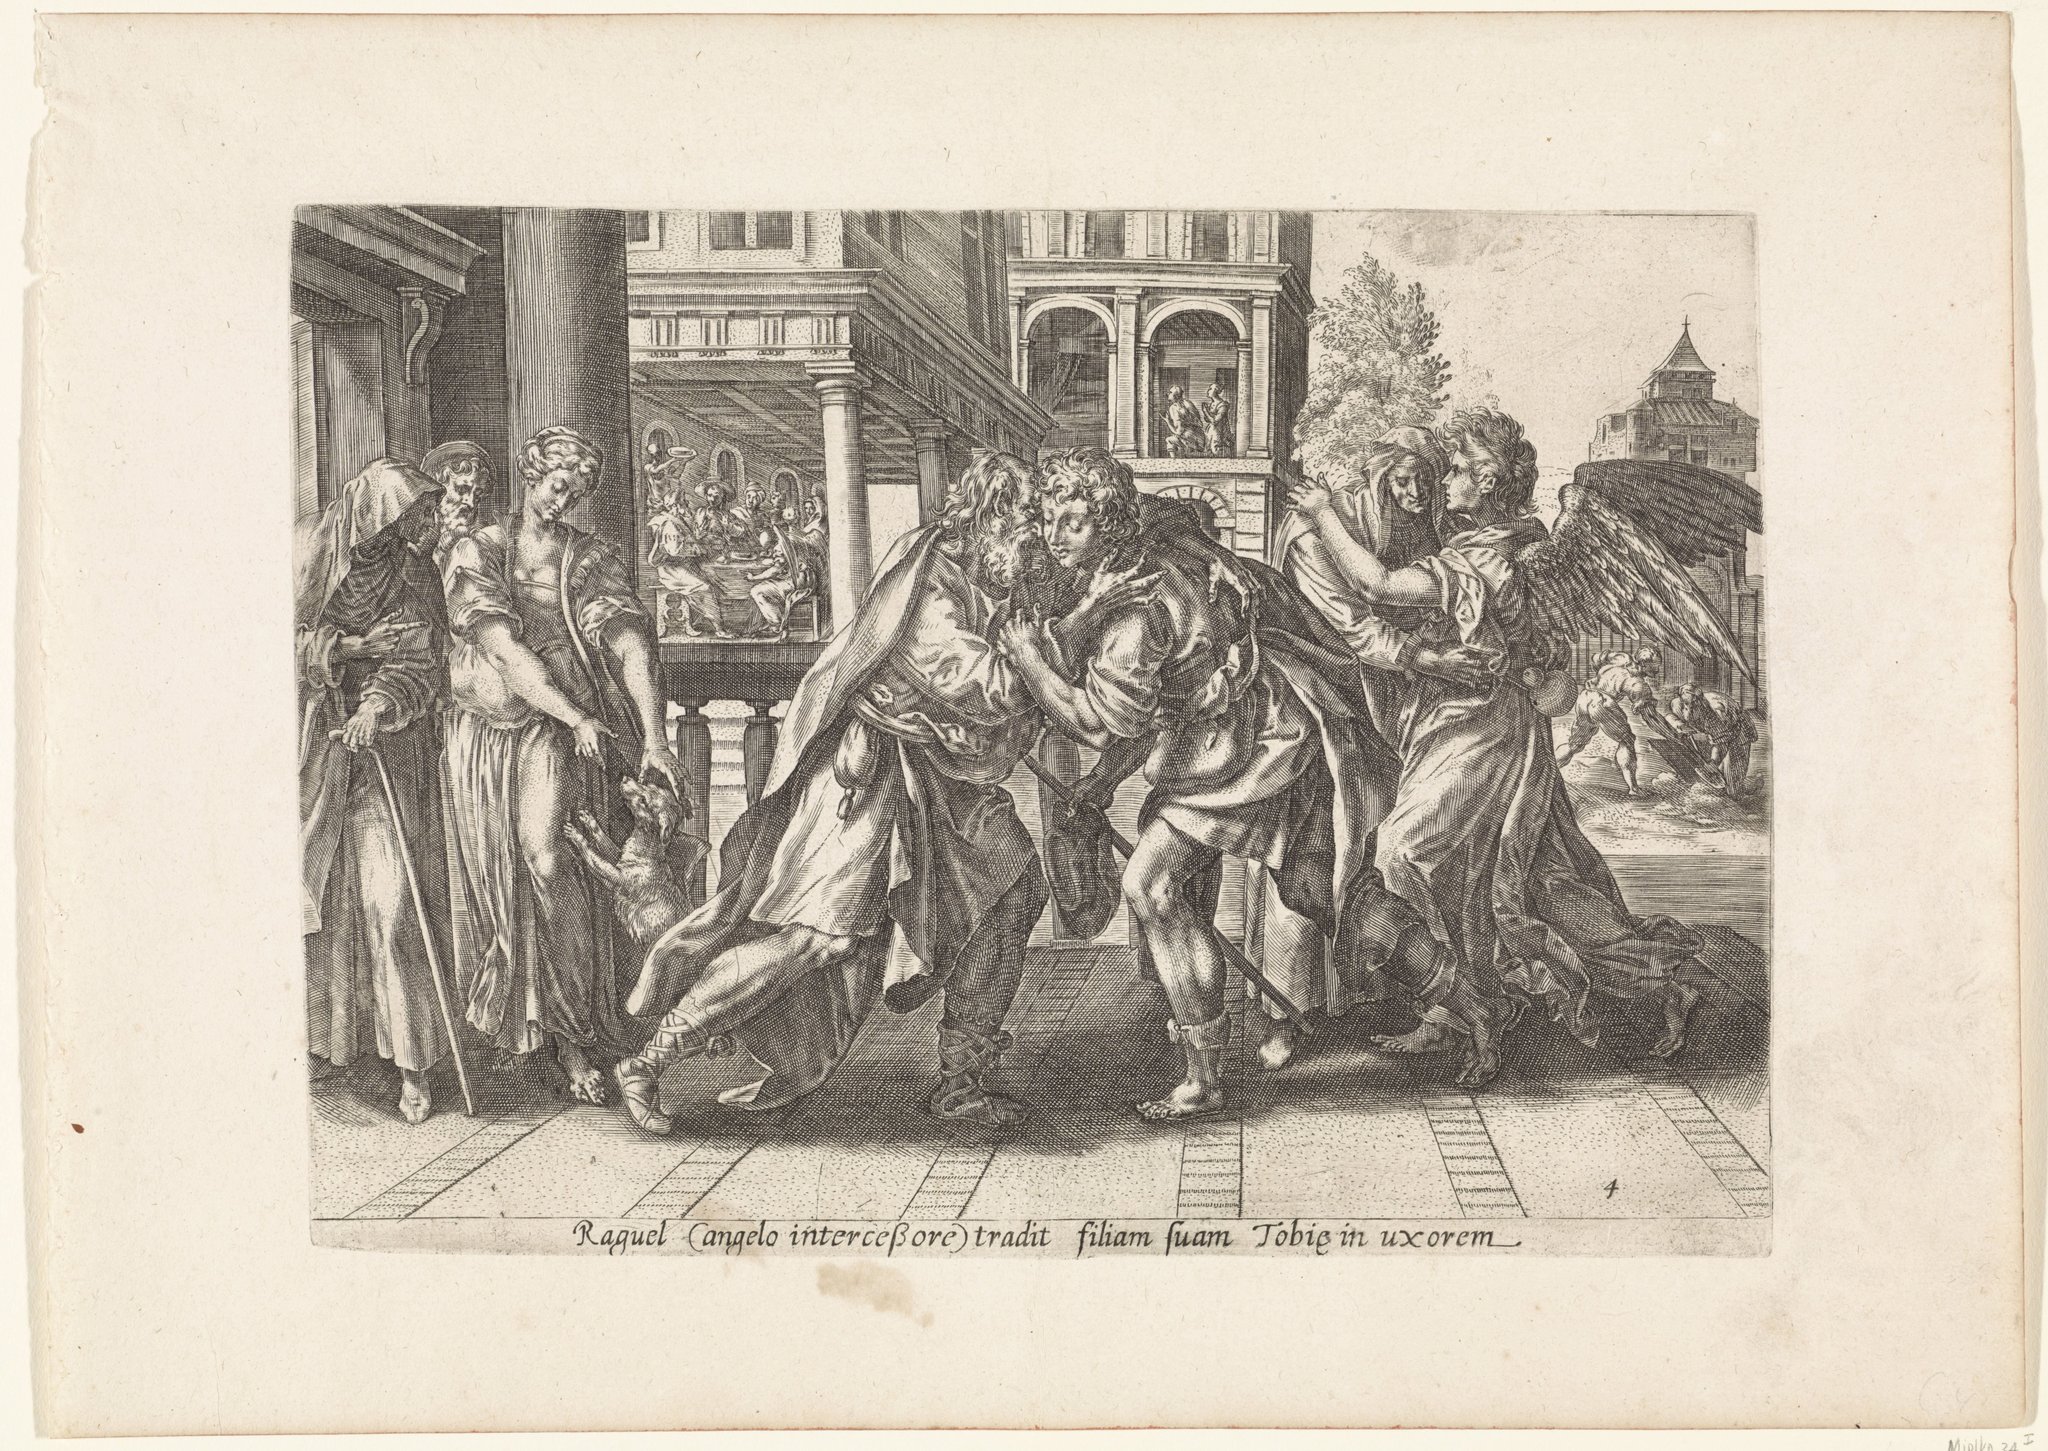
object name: print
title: Geschiedenis van Tobias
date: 1585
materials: paper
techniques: engraving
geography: antwerp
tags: tobias and the angel in raguel's house, tobias and sarah praying, raguel digging a grave for tobias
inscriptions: collector's mark: Lugt 2228, collector's mark: Lugt 2760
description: Raguel ontvangt Tobias en omhelst hem. Zijn vrouw Edna omhelst de engel. Op de achtergrond worden Tobias en de engel gastvrij ontvangen aan tafel door hen. Raguel geeft zijn dochter Sara ten huwelijk aan Tobias. In de slaapkamer knielen Tobias en Sara in gebed om Gods zegen en bescherming over hun huwelijk te vragen. Rechts graven de dienaren van Raguel een graf. Onderaan in de marge een verklarende tekst in het Latijn. Naar Tobit 7-8.